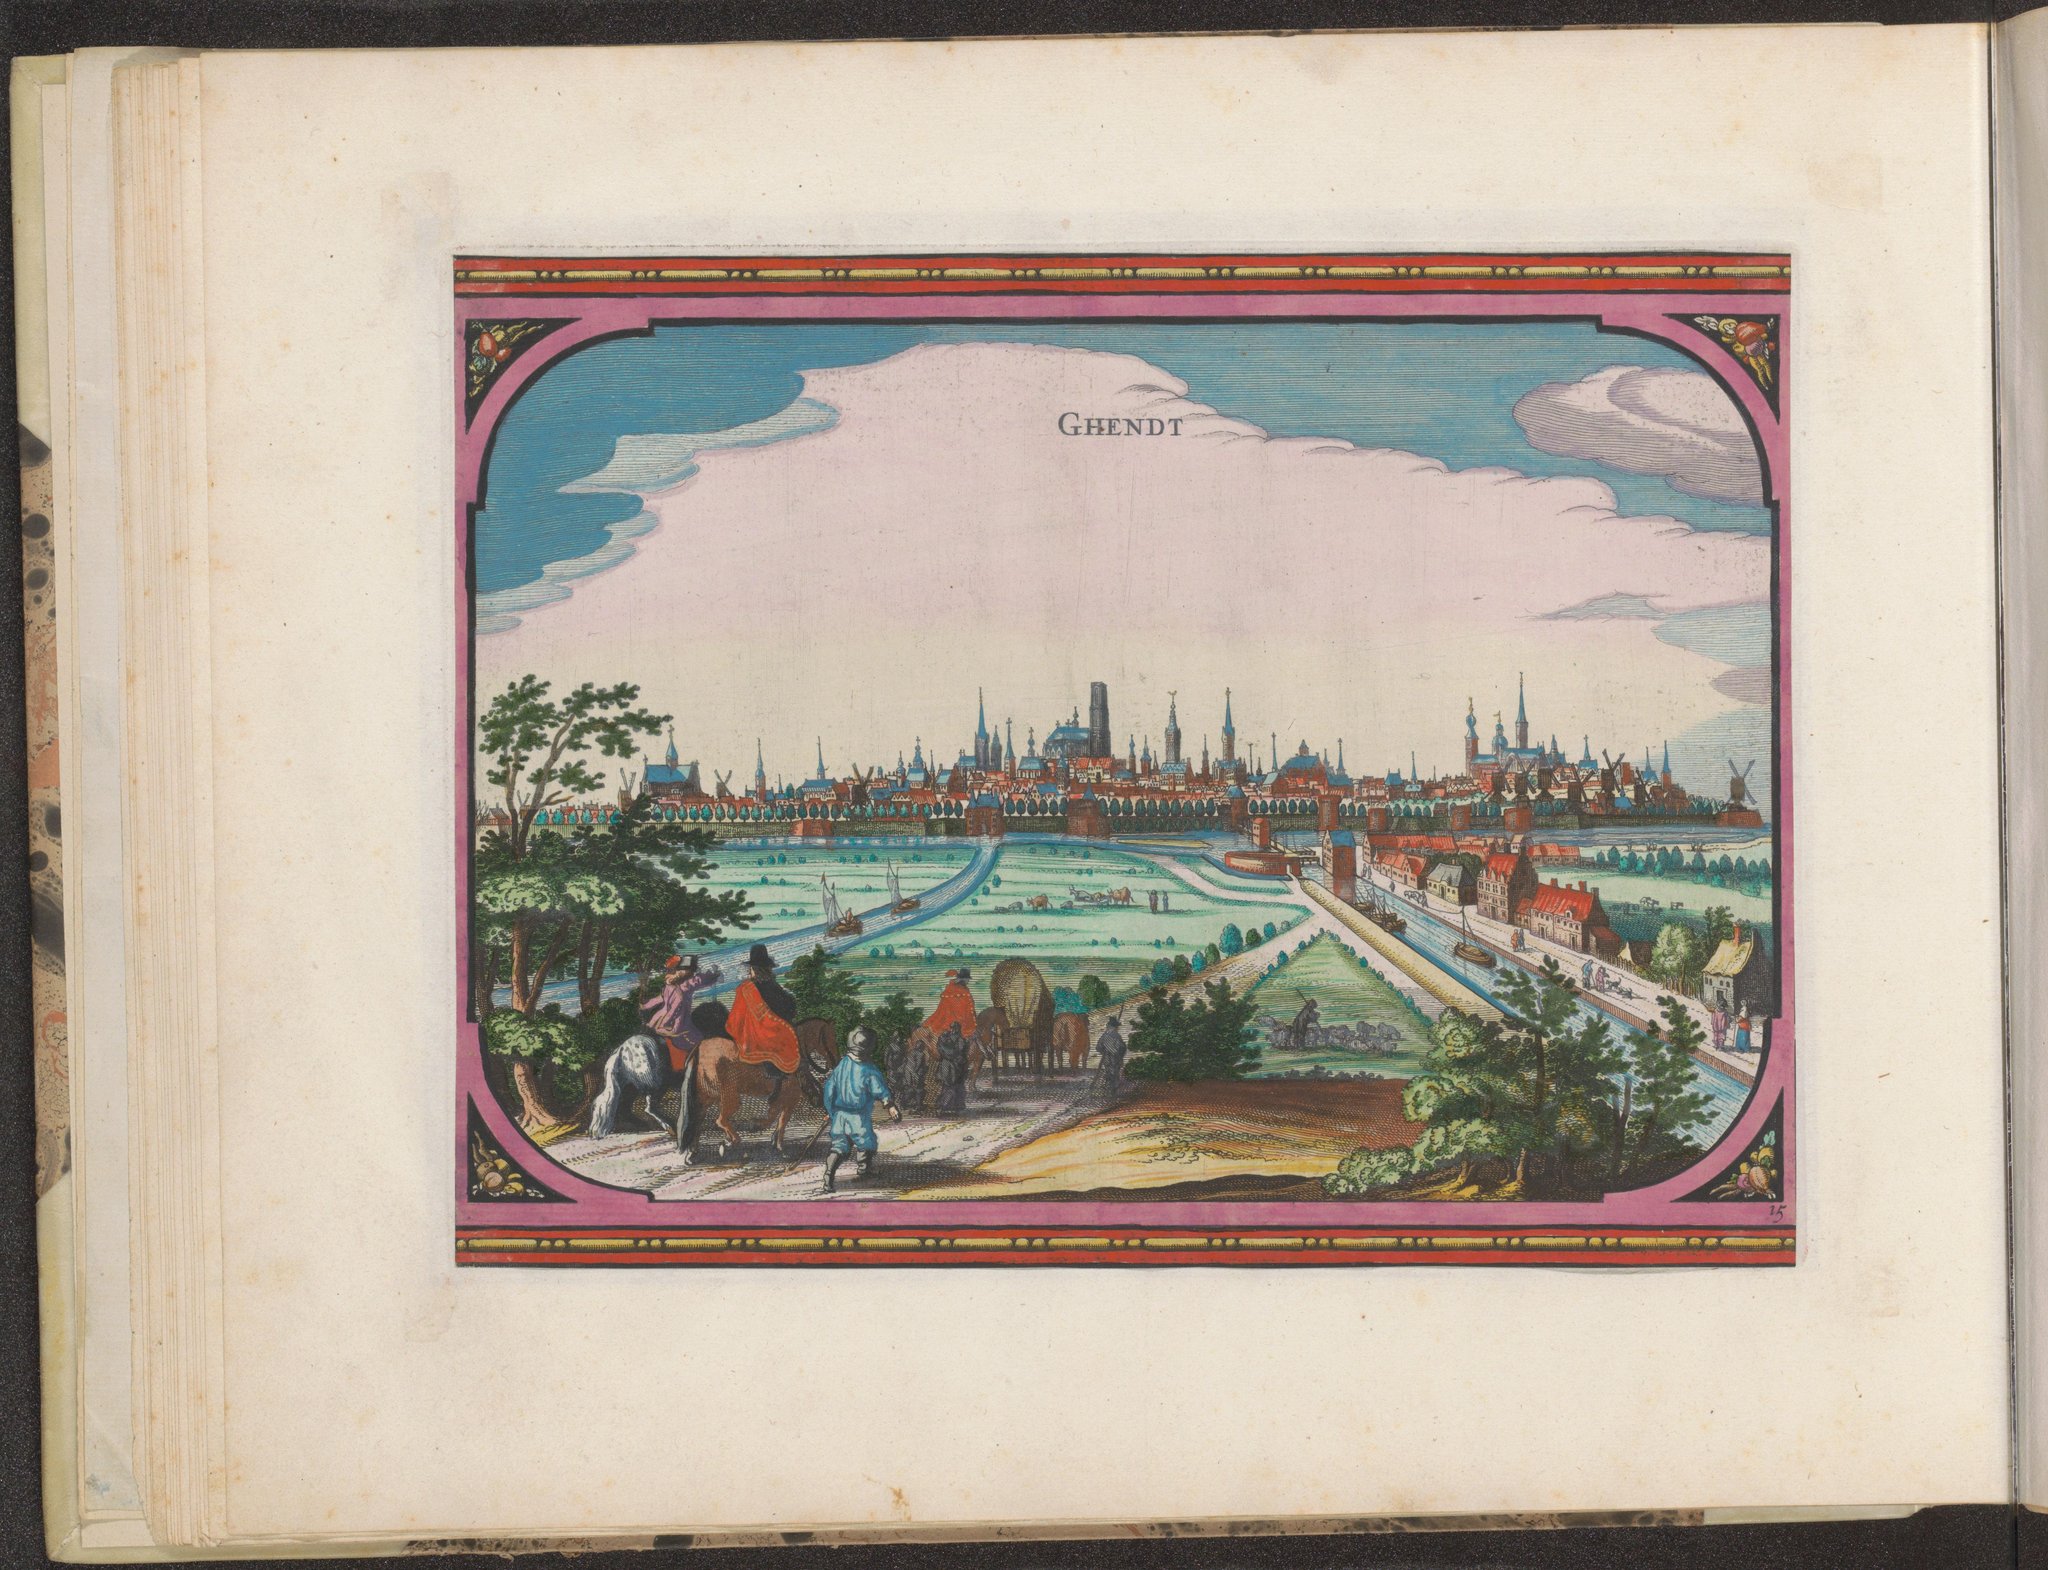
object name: album leaf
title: Theatrum praecipuarum urbium ducatus Brabantiae necnon comitatuum Flandriae et Zelandiae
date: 1657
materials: paper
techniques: etching, hand coloring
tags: city-view, and landscape with man-made constructions, 'en route', traveller under way, ghent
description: Gezicht op de stad Gent met op de voorgrond onder meer enkele ruiters en een huifkar. De prent maakt deel uit van een album.